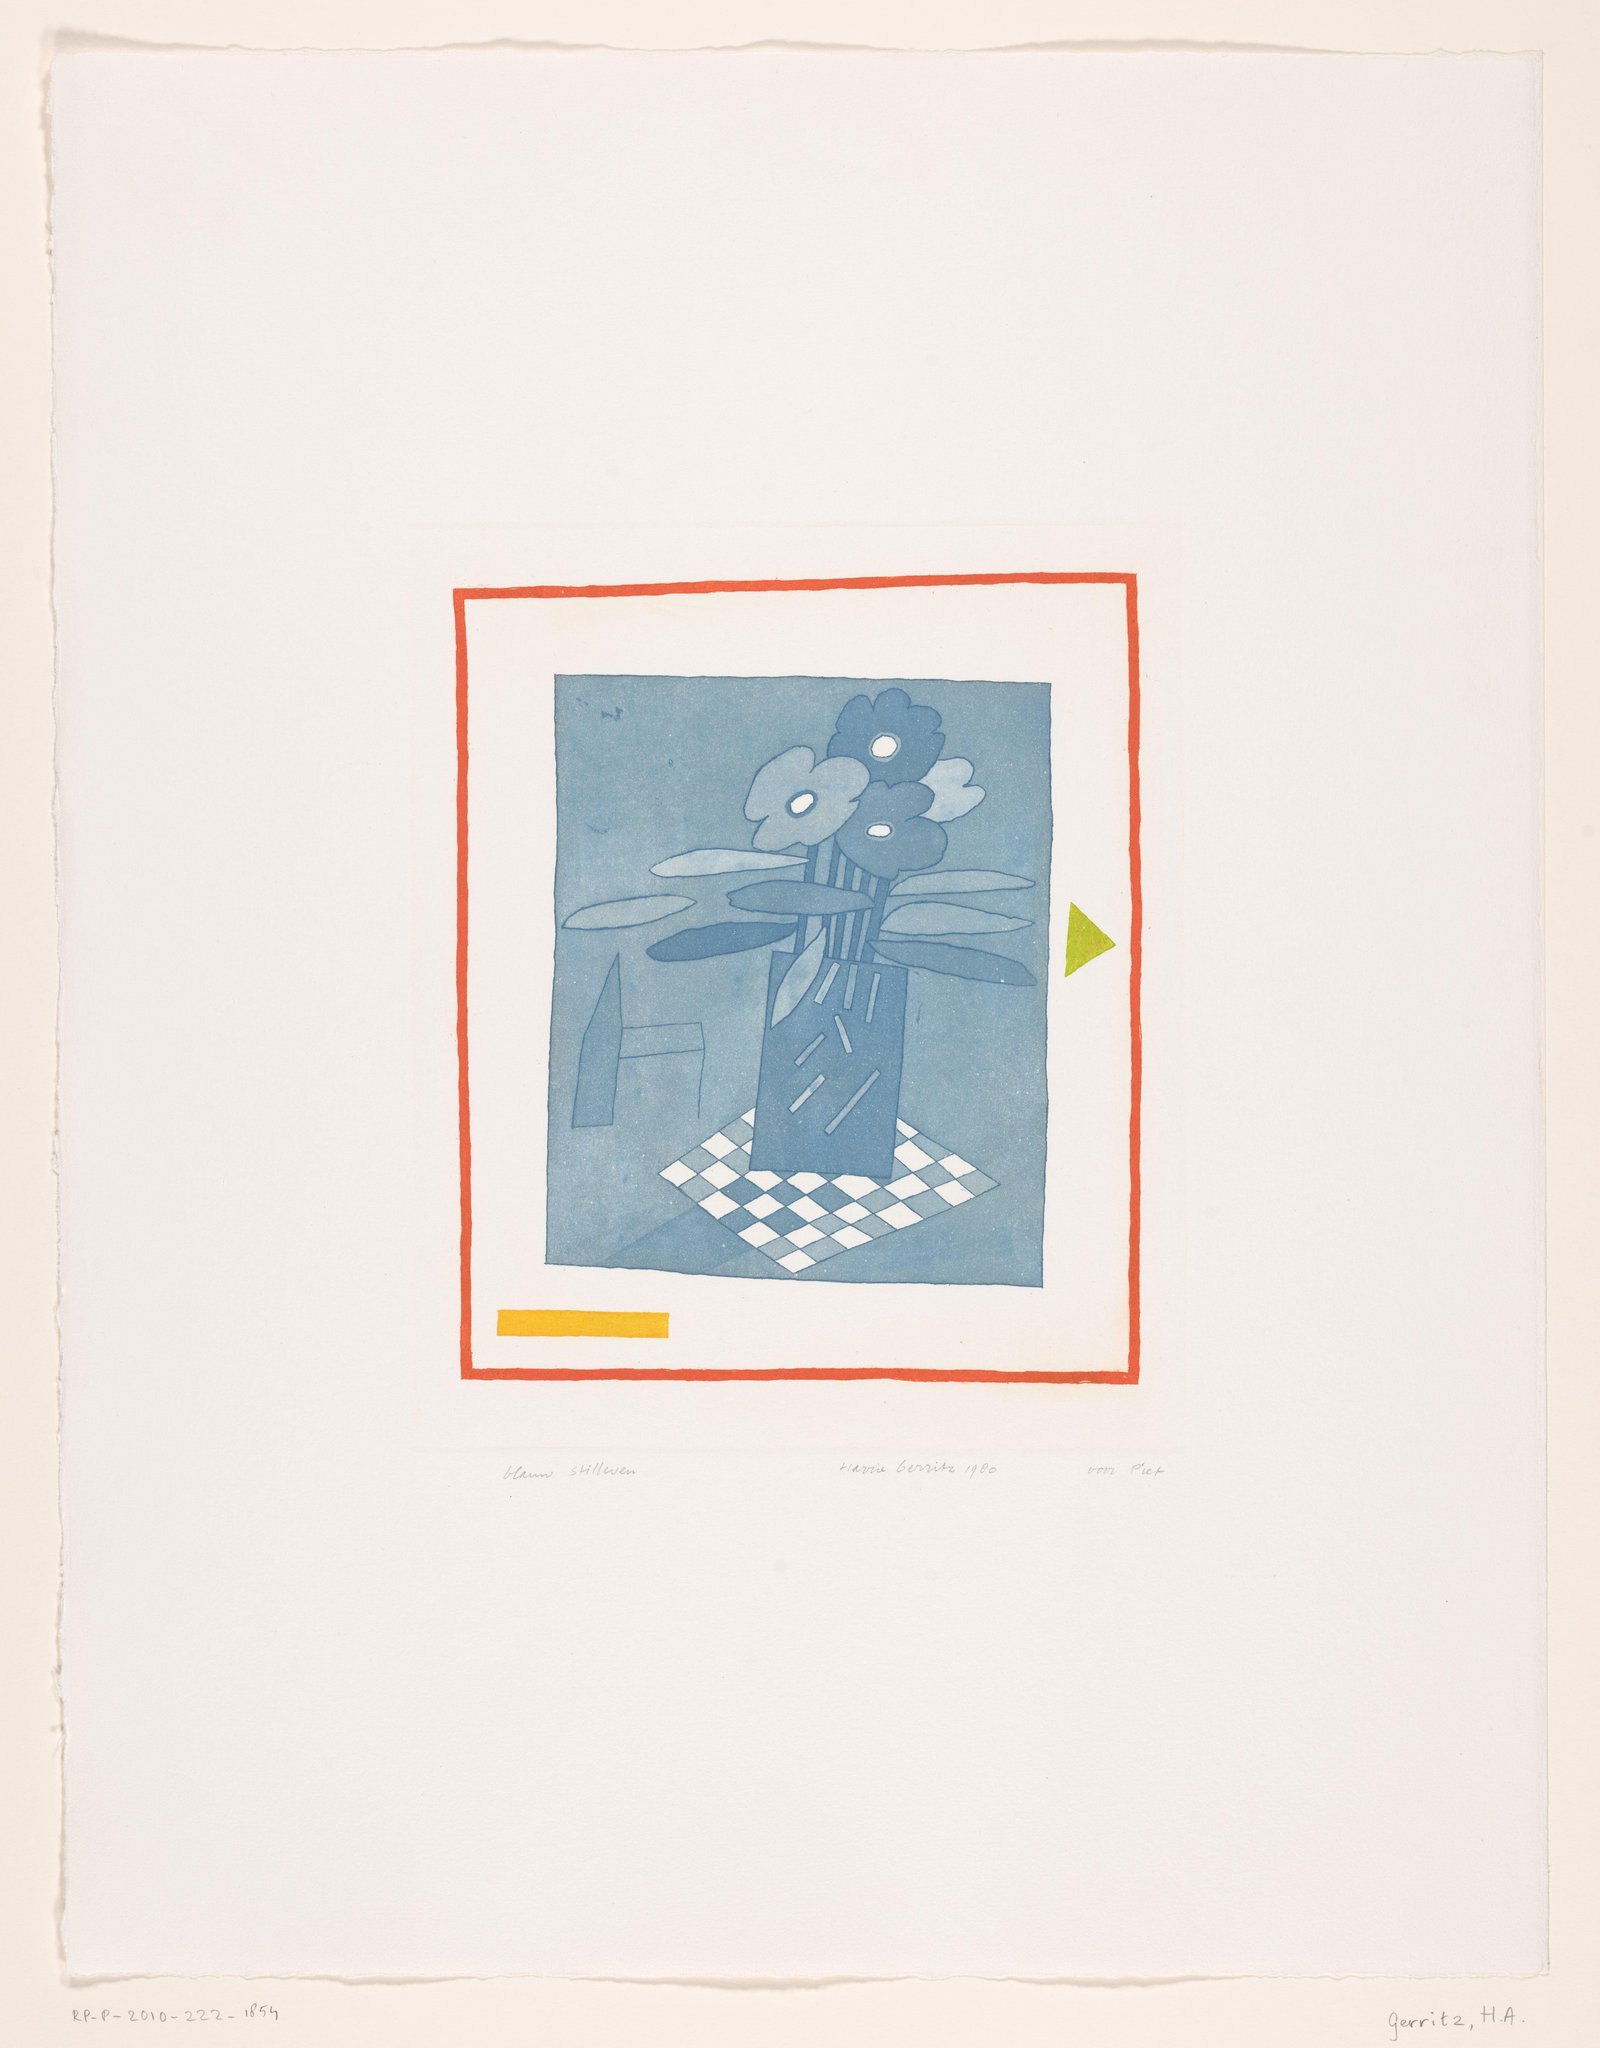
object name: print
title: Blauw stilleven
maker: harrie a. gerritz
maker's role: draughtsman, painter, print maker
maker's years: 1940-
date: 1980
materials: paper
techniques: aquatint, etching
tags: flowers, building of church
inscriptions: inscription: ‘PC’, dedication: ‘voor Piet’, collector's mark: Lugt 2228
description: Vaas met bloemen op een geblokt kleed met op de achtergrond een kerk.